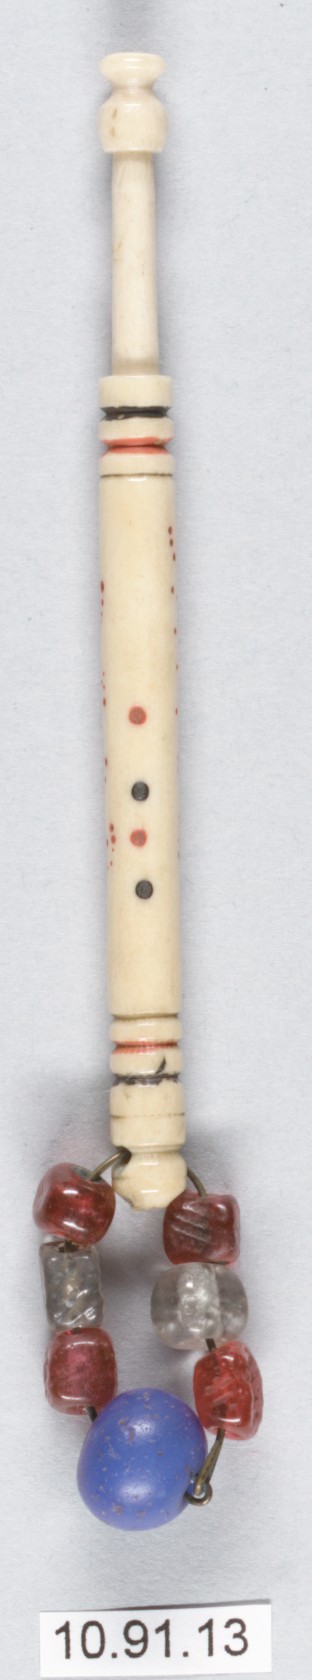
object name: bobbin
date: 1801-1900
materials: bone